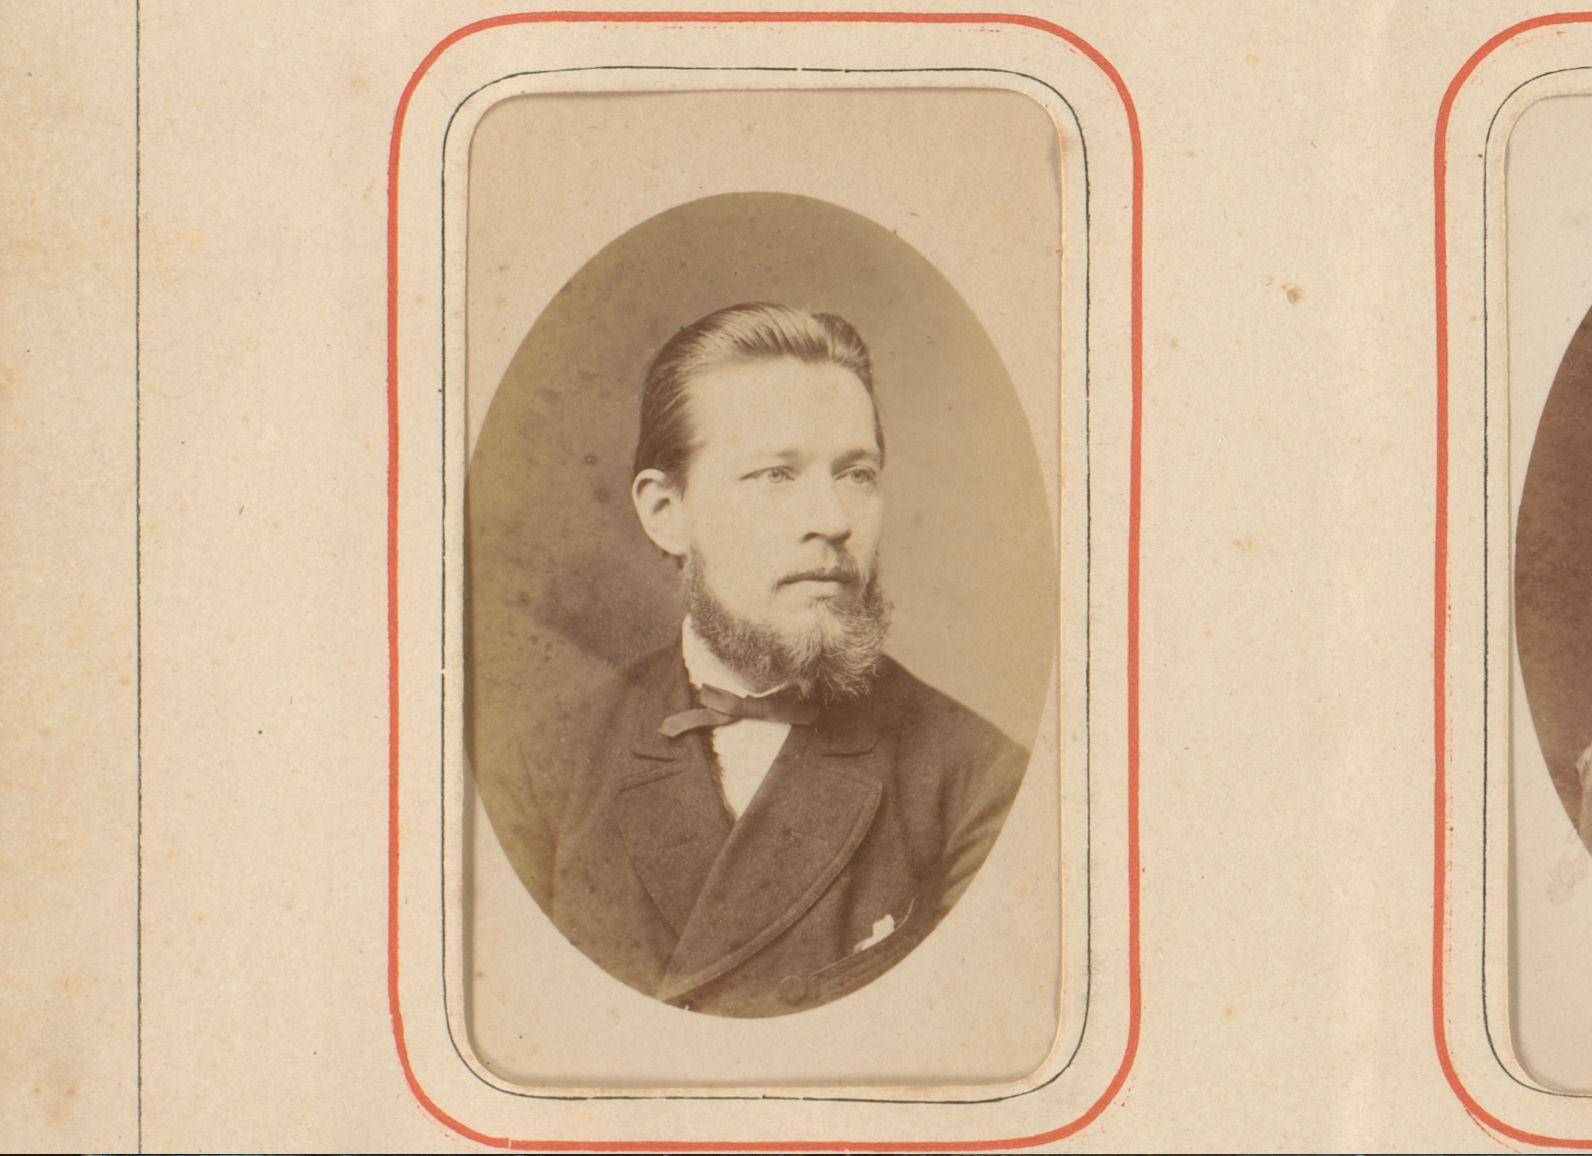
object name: album leaf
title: Portret van een onbekende man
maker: johannes baer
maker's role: fotograaf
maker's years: 1840-1912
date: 1871-1891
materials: cardboard, paper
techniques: albumen print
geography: rotterdam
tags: anonymous historical person portrayed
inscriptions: address: ‘Schiedamschen Singel/ 55/ ROTTERDAM.’